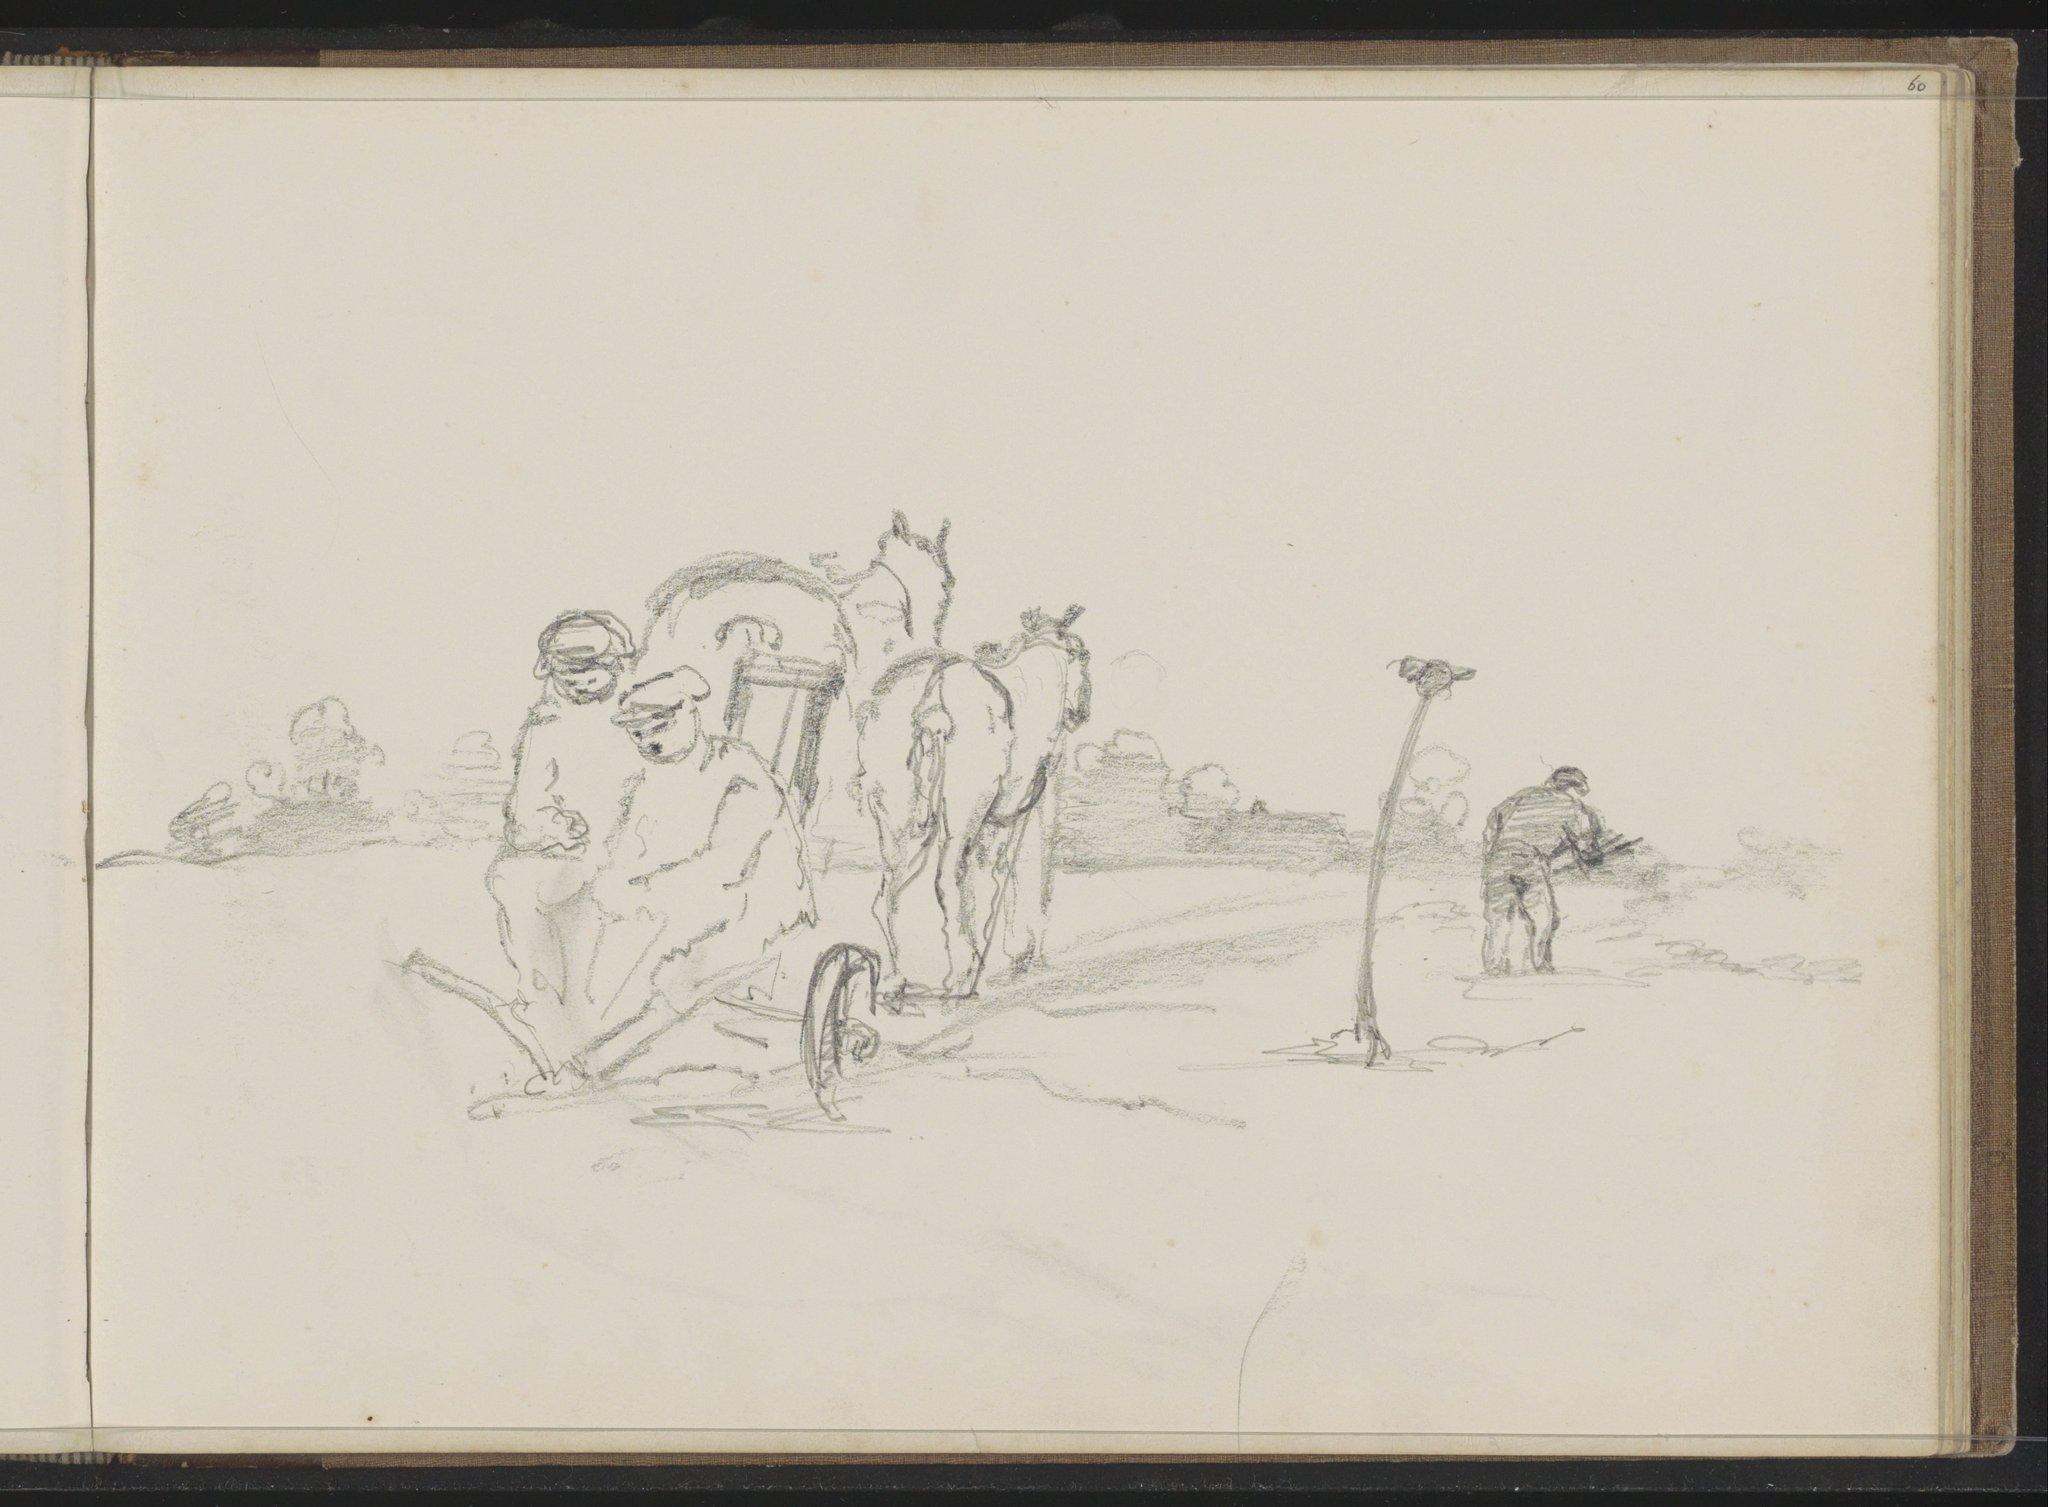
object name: sketchbook leaf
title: Twee mannen op een ploeg in een weiland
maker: hendrik valkenburg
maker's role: draughtsman, painter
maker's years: 1826-1896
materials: paper, pencil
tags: soil cultivation, meadow, pasture (+ landscape with figures, staffage)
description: Voor de ploeg zijn twee paarden gespannen. Op de achtergrond in het weiland een derde man met een landbouwwerktuig. Blad 60 recto uit een schetsboek met 77 bladen.